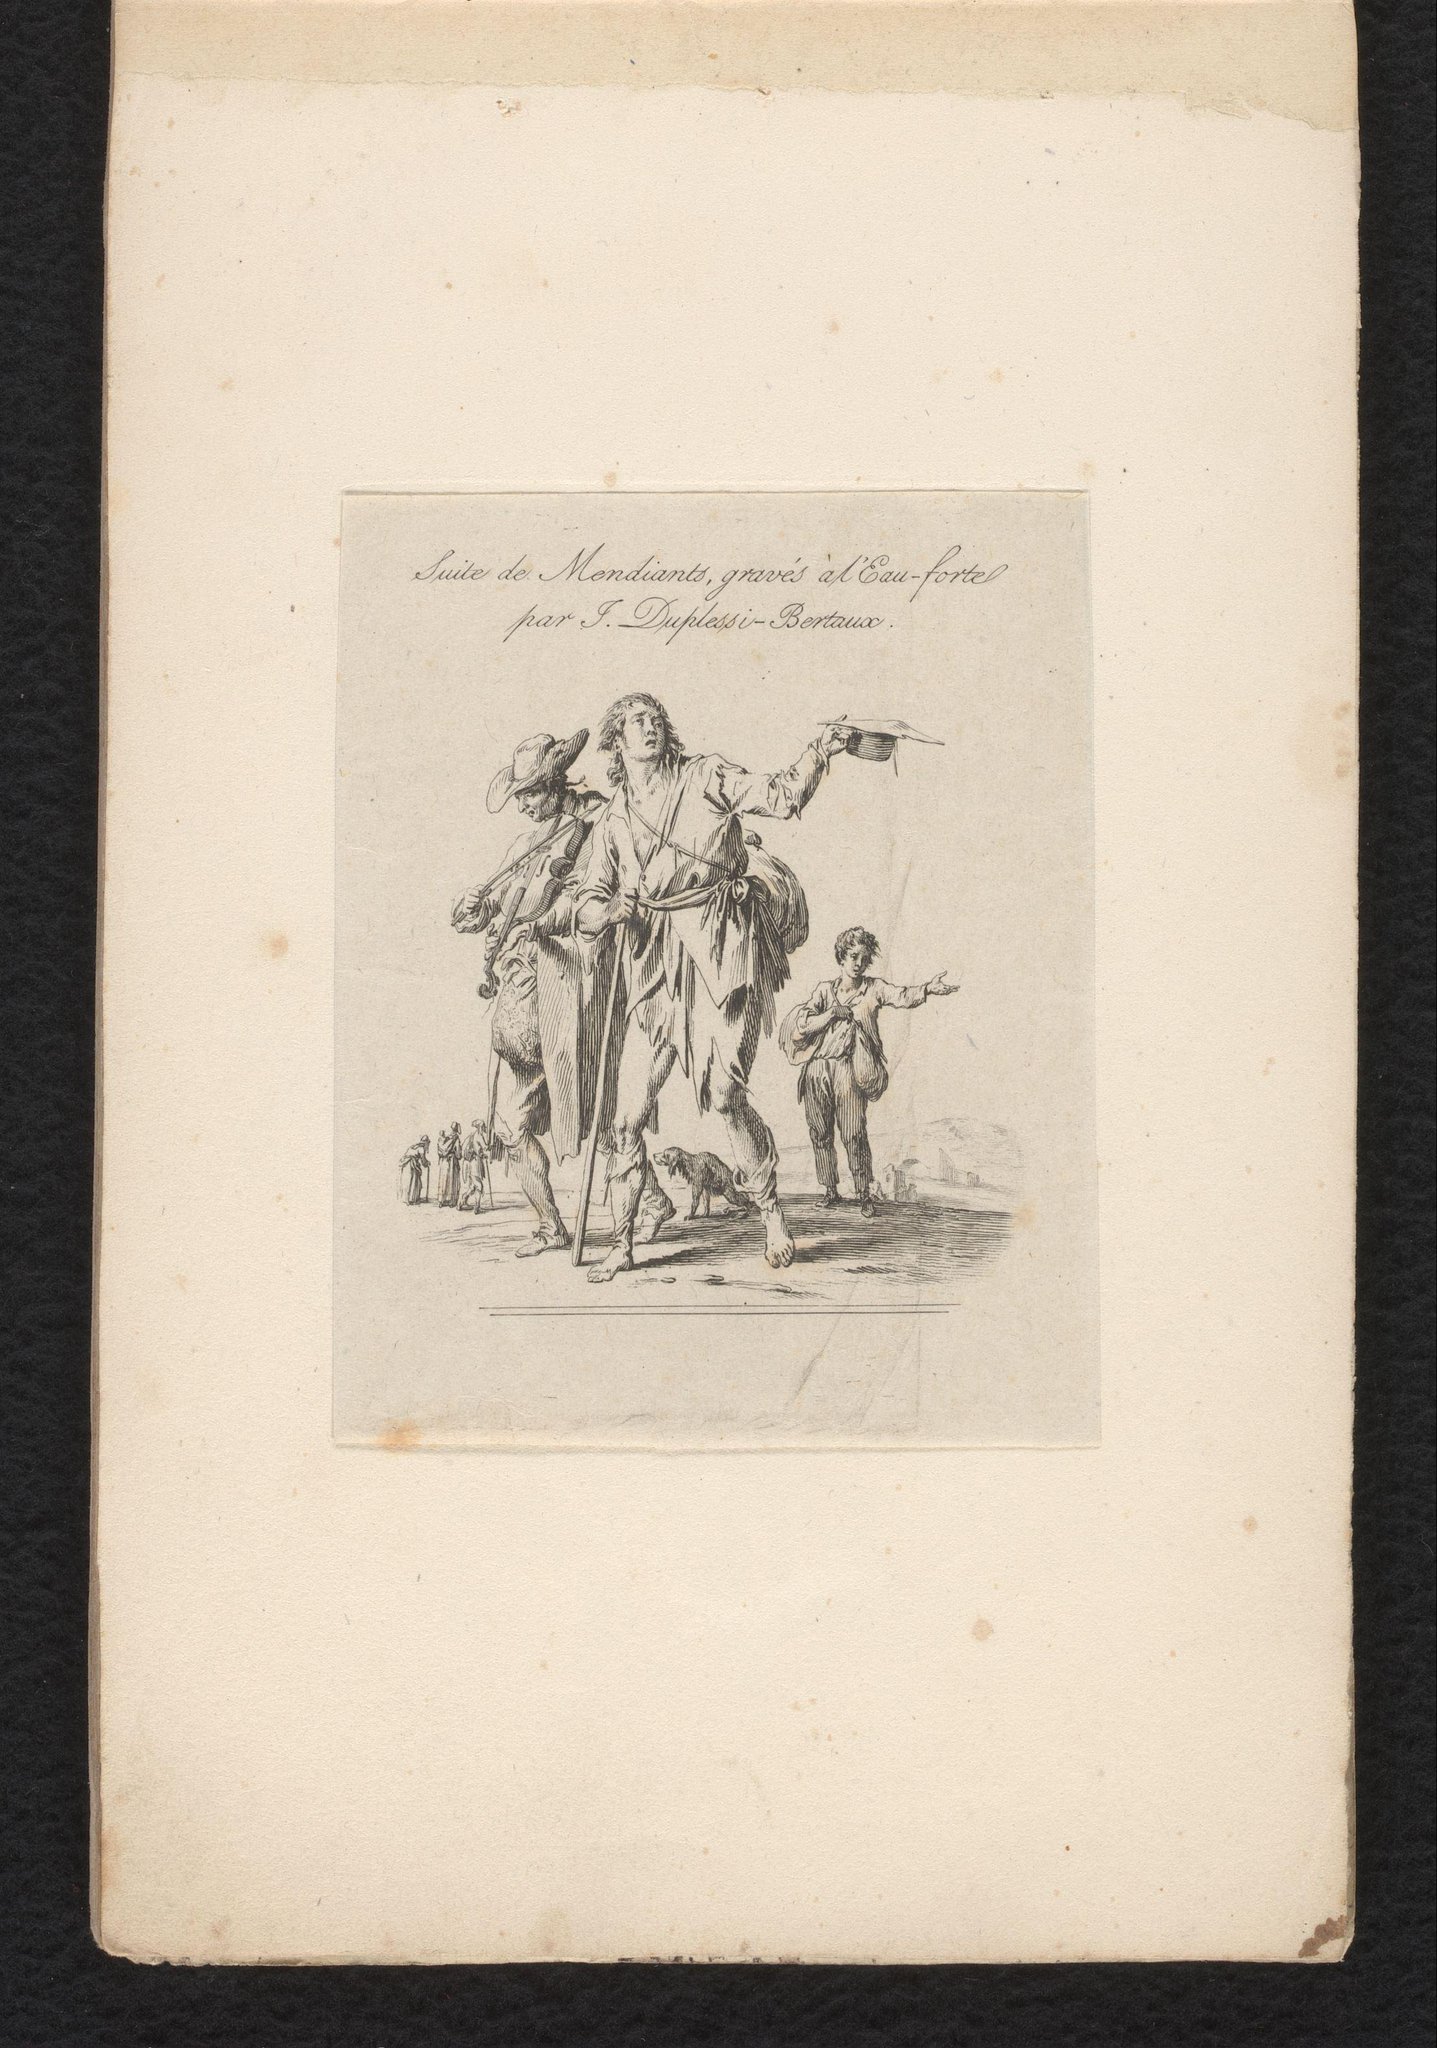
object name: print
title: Titelprent met bedelaars met viool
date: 1798-1806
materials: paper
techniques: engraving, etching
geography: paris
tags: clothed in rags, violin, fiddle, beggar